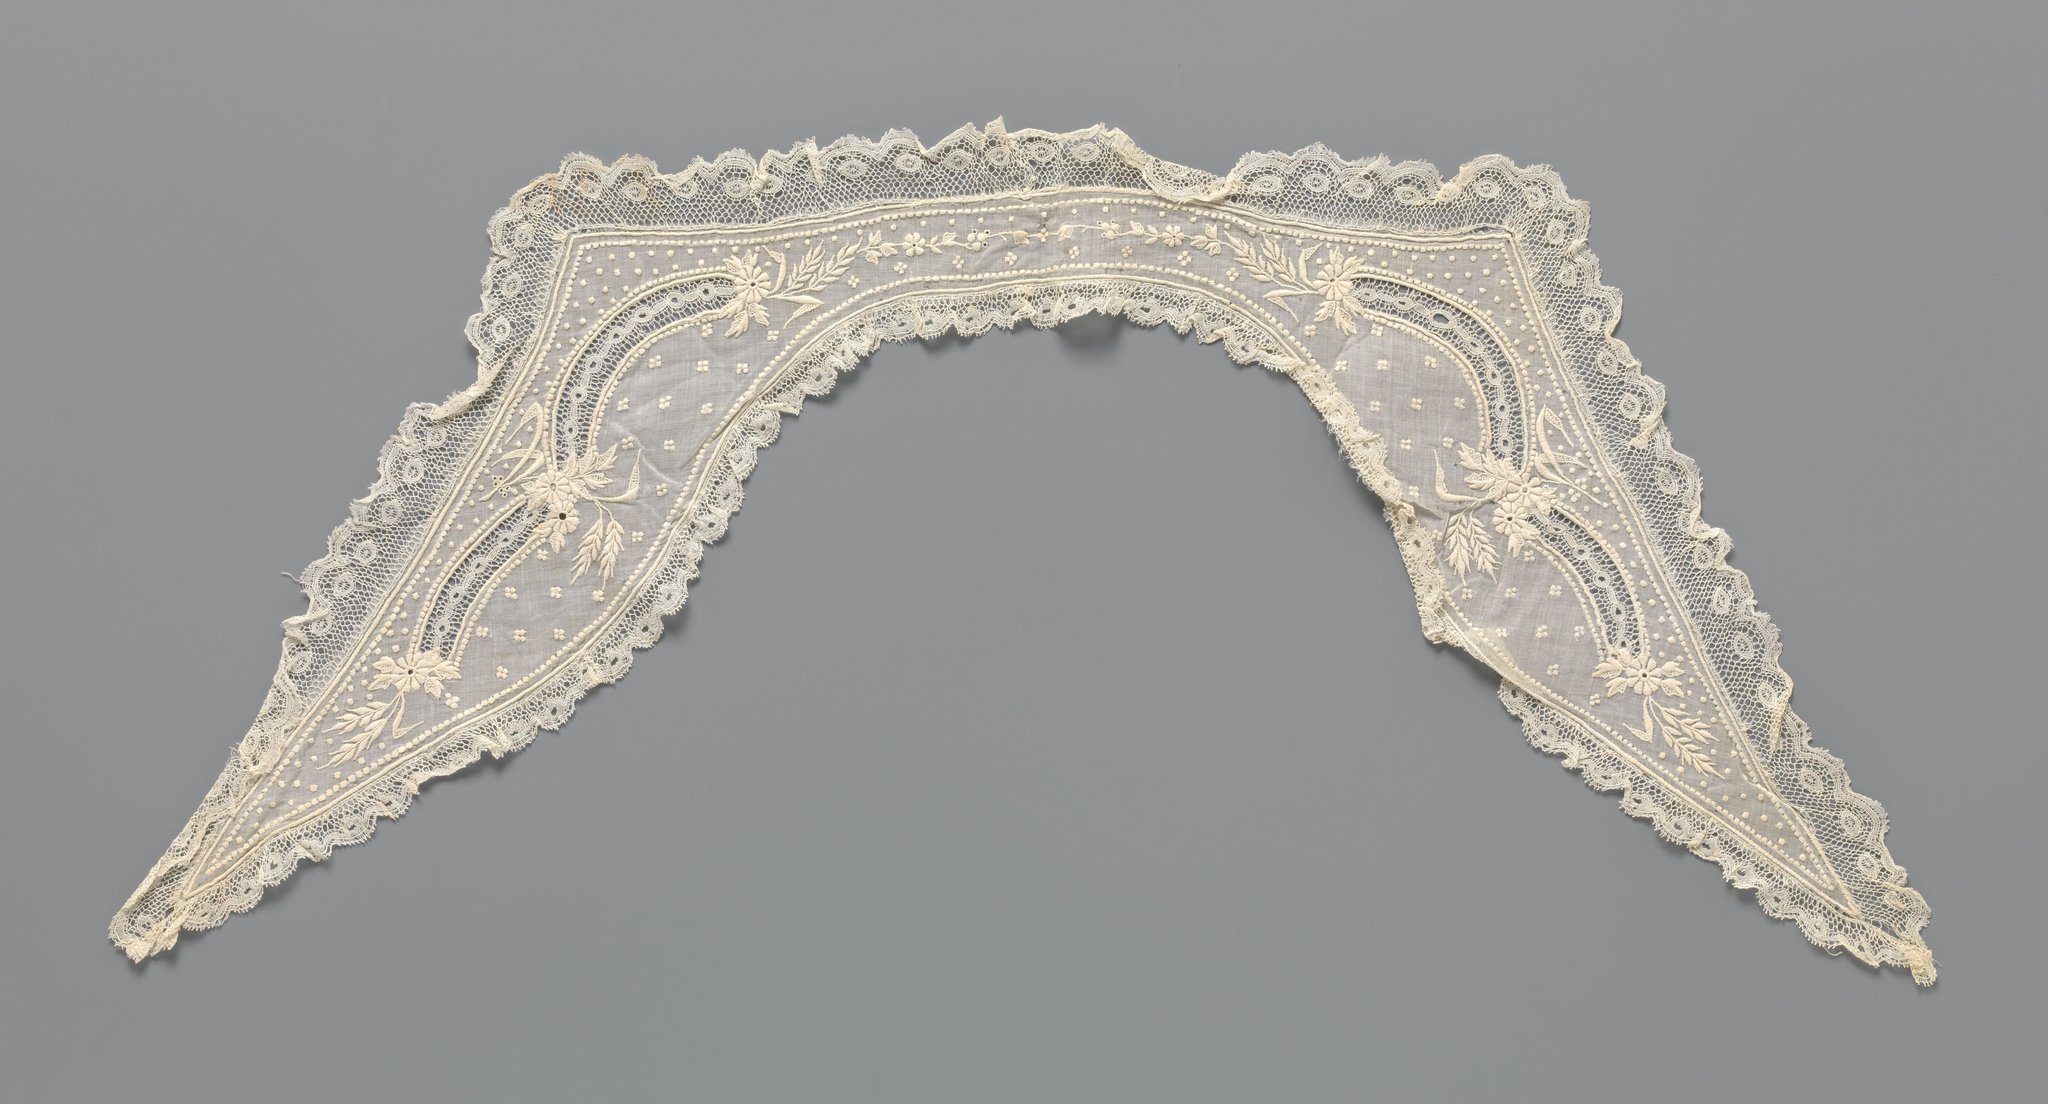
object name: collar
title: Sjaalkraag van batist met borduurwerk met korenaren en incrustaties van machinale kant in de vorm van twee vlakke bogen in elke punt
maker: Anonymous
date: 1885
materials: textile, linen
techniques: embroidered, lace, weave, embroidery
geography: netherlands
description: Sjaalkraag van naturelkleurige geborduurde batist, rondom afgewerkt met stroken machinale kant: machinale Valenciennes-kant. Smal trapeziumvormig model met spitse punten. Vanaf de rechte onderkant richting de punten zijn twee incrustaties van kant aangebracht, aan elke kant twee aan elkaar geschakelde vlakke bogen. Bij het knooppunt en de uiteinden van de bogen staat borduurwerk - witwerk met plumetis - met twee korenaren, één of twee rozetbloempjes en geknakte grassprieten. Het batist is aan de binnenzijde bezaaid met bloempjes en aan de buitenzijde voller bezaaid met moesjes. De kantstroken hebben een schulpenrand van boogjes met boven elke schulp een ovaaltje.